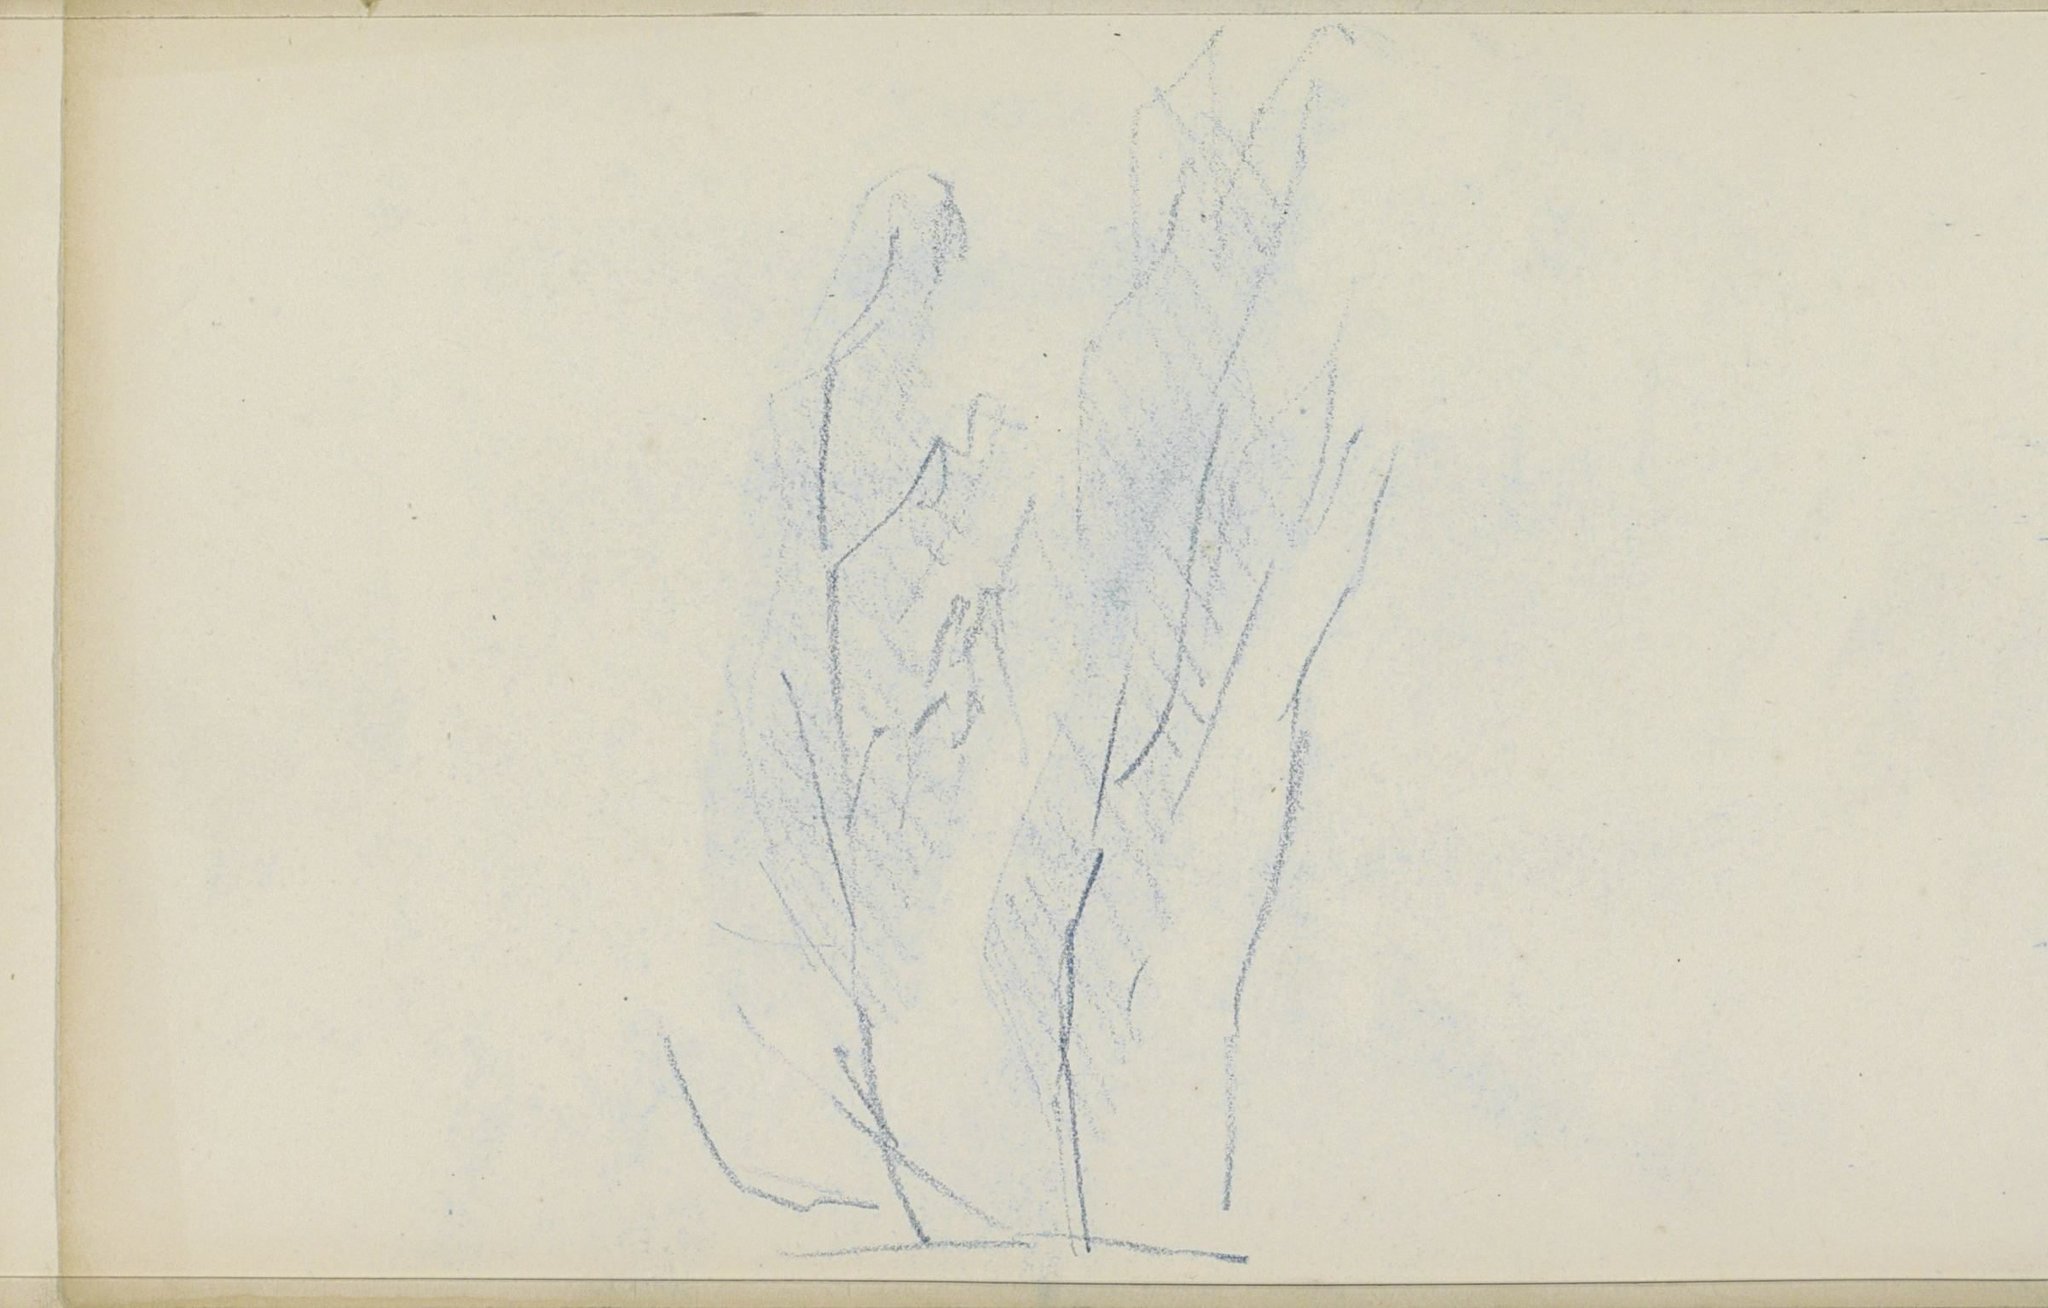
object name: sketchbook leaf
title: Bomen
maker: jozef israëls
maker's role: draughtsman, painter, print maker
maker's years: 1824-1911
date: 1834-1911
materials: chalk, paper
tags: trees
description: Blad 15 verso uit een schetsboek met 37 bladen.